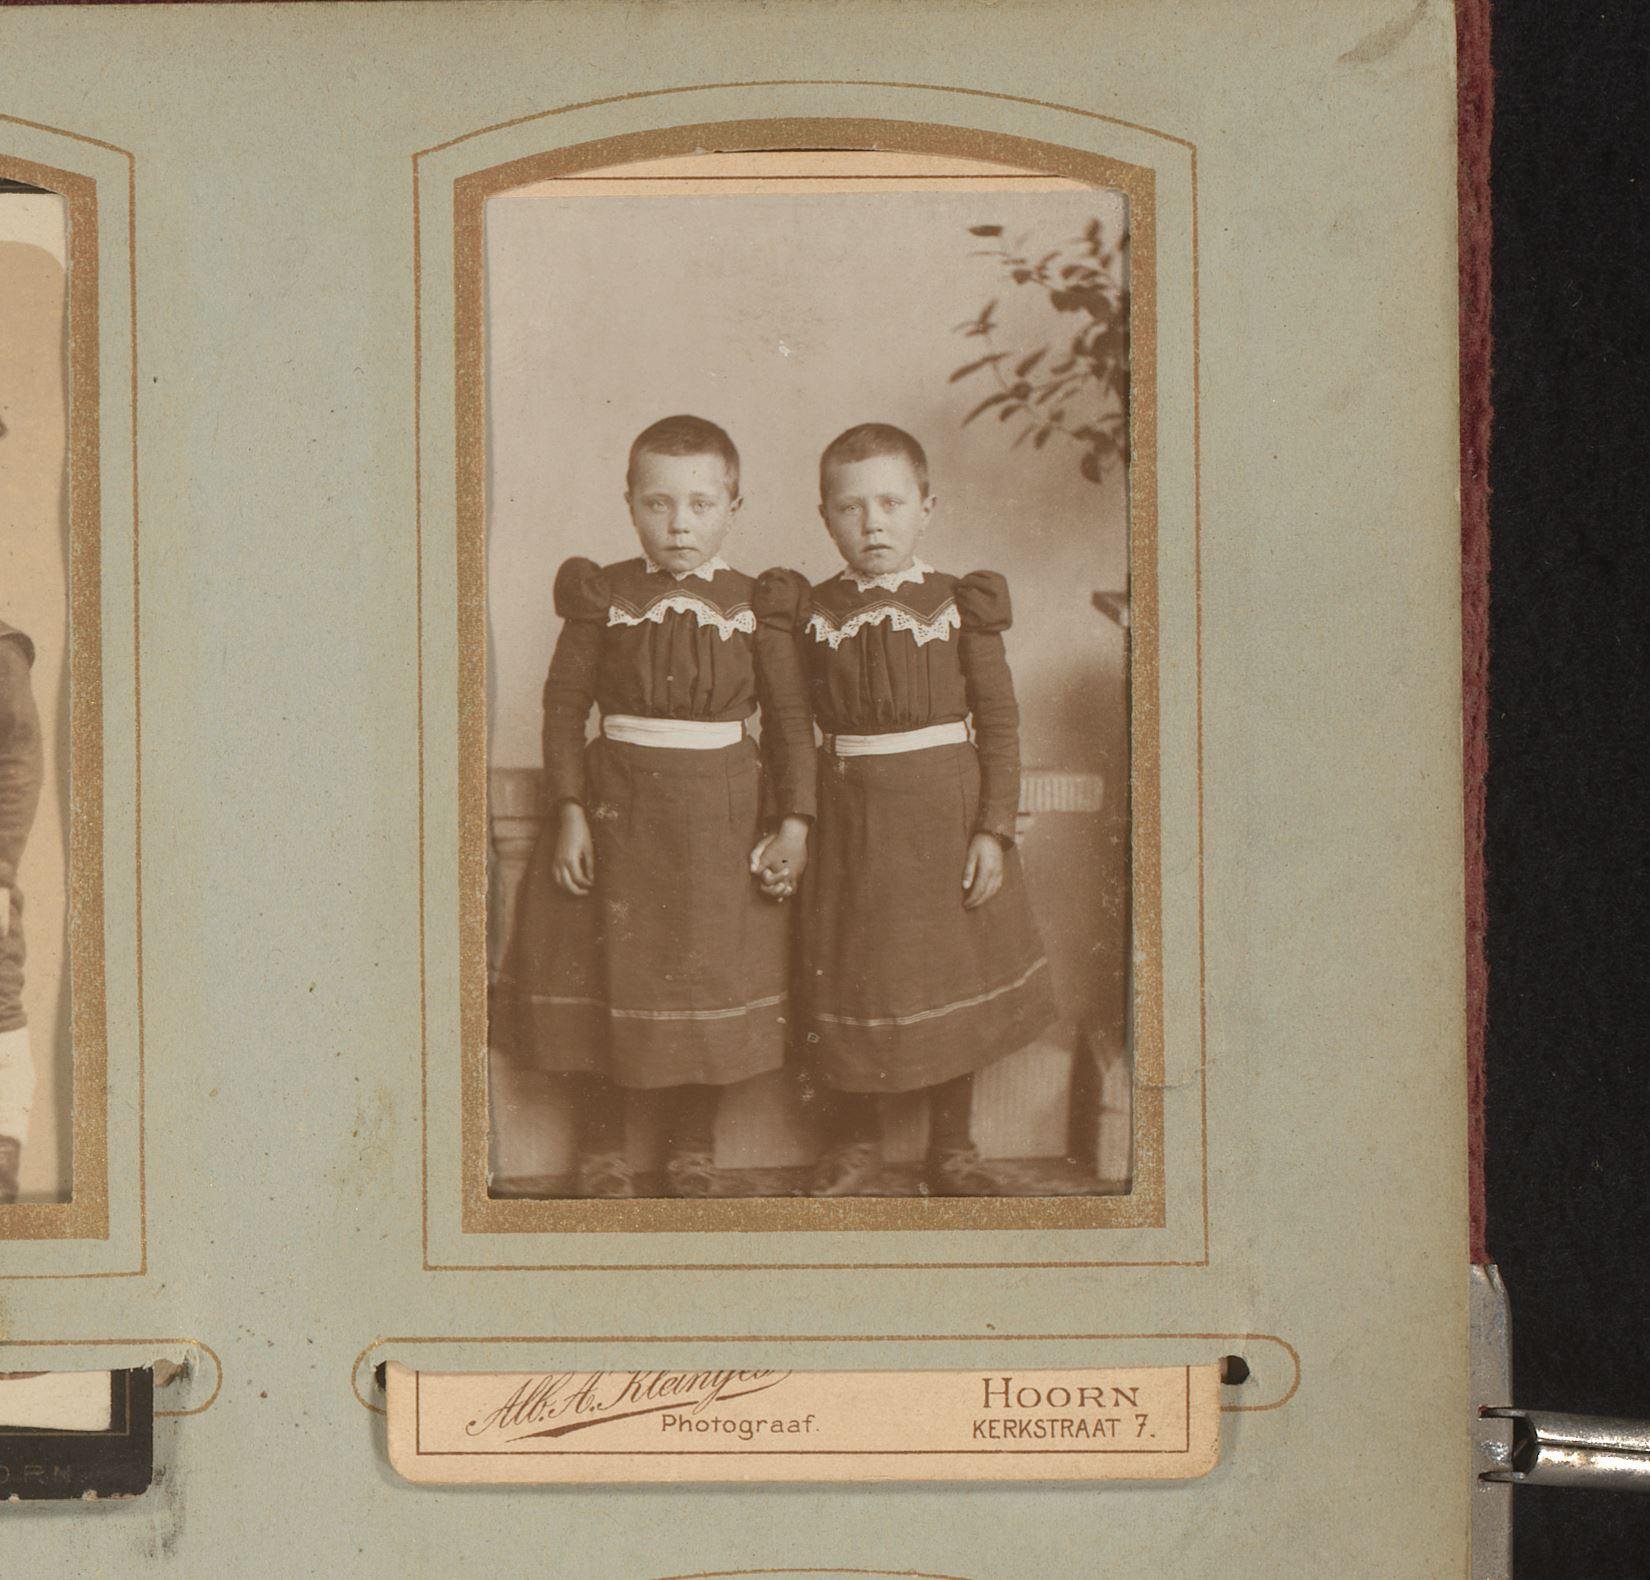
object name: album leaf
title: Portret van twee meisjes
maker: albert a. kleintjes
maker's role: fotograaf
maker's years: 1854-1942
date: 1883-1913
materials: cardboard, photographic support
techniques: collodion silver print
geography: hoorn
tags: historical persons - bb - woman, girl (child between toddler and youth) (+ two persons)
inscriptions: inscription: ‘Alb. A. Kleintjes/ Photograaf/ Hoorn/ Kerkstraat./ 4e huis v.d. Kaasmarkt./ Nabestellingen en Vergrootingen van deze en andere/ Portretten kunnen ten allen tijde geleverd worden.’